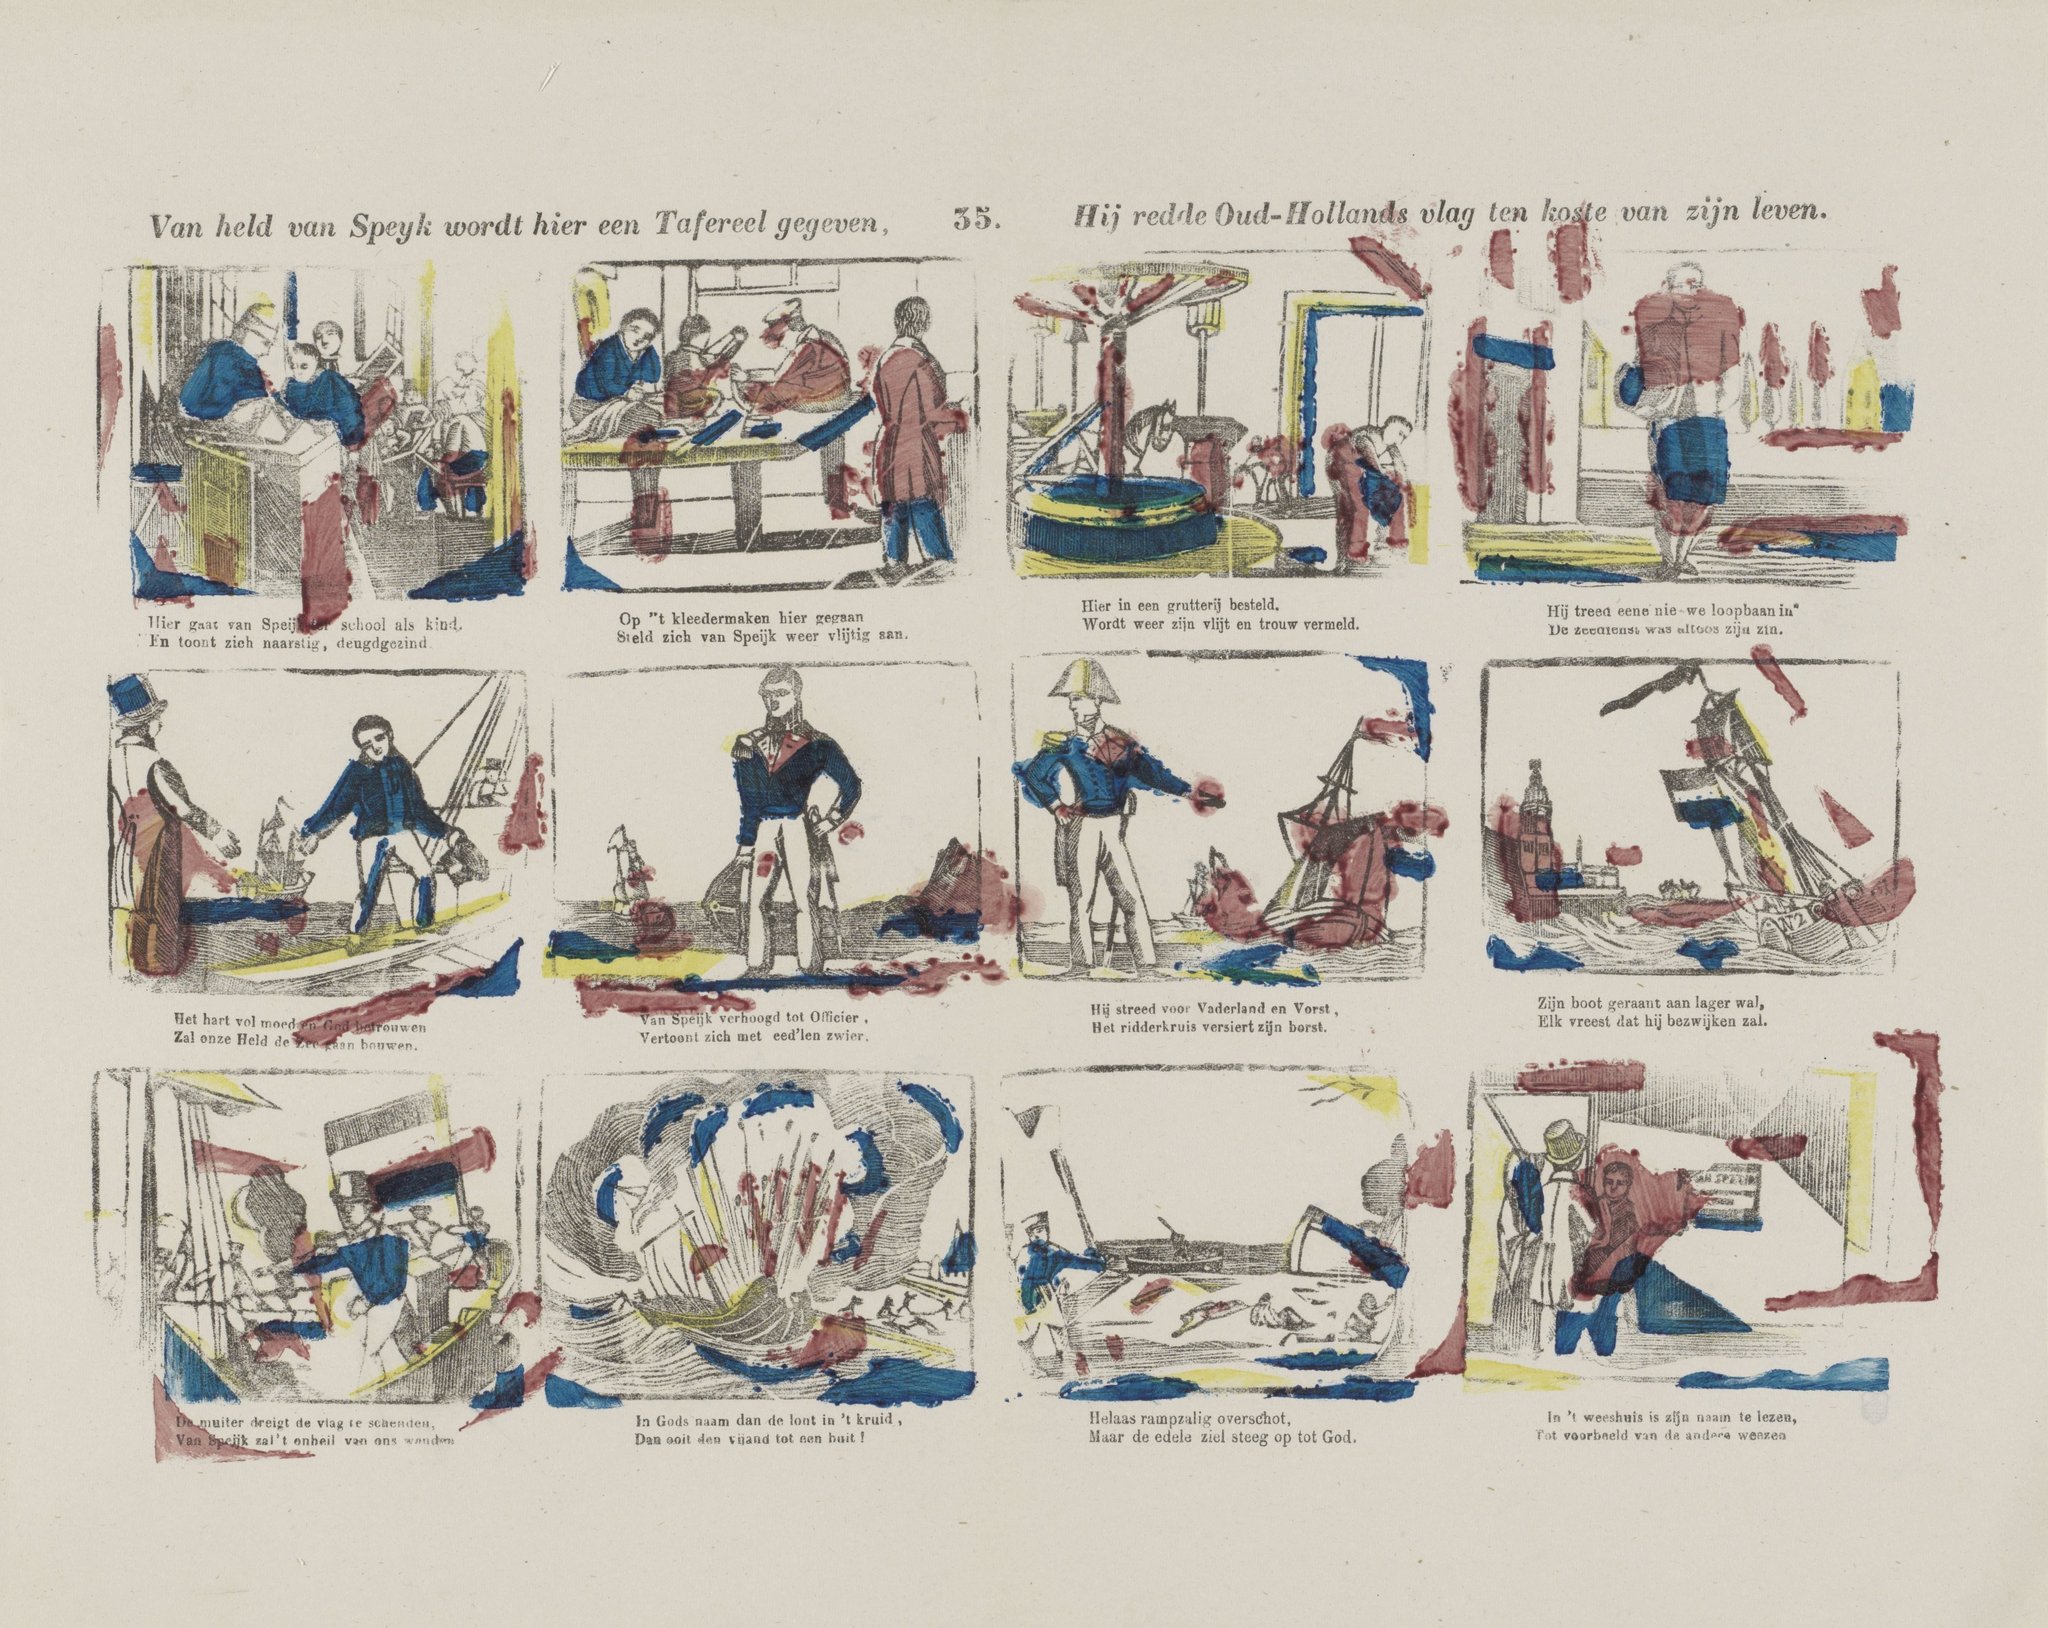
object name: popular print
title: Van held van Speyk wordt hier een tafereel gegeven, / Hij redde Oud-Hollands vlag ten koste van zijn leven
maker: Anonymous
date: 1848-1881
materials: paper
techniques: colour, letterpress printing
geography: netherlands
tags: amsterdam, antwerp, jan van speyk, battle, revolution, revolt, orphans, netherlands, belgium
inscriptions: collector's mark: Lugt 2760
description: Blad met 12 voorstellingen over het leven en de zelfopoffering van J.C.J. van Speyk tijdens de strijd tegen de Belgen. Onder elke afbeelding een tweeregelig vers. Genummerd midden boven: 35.